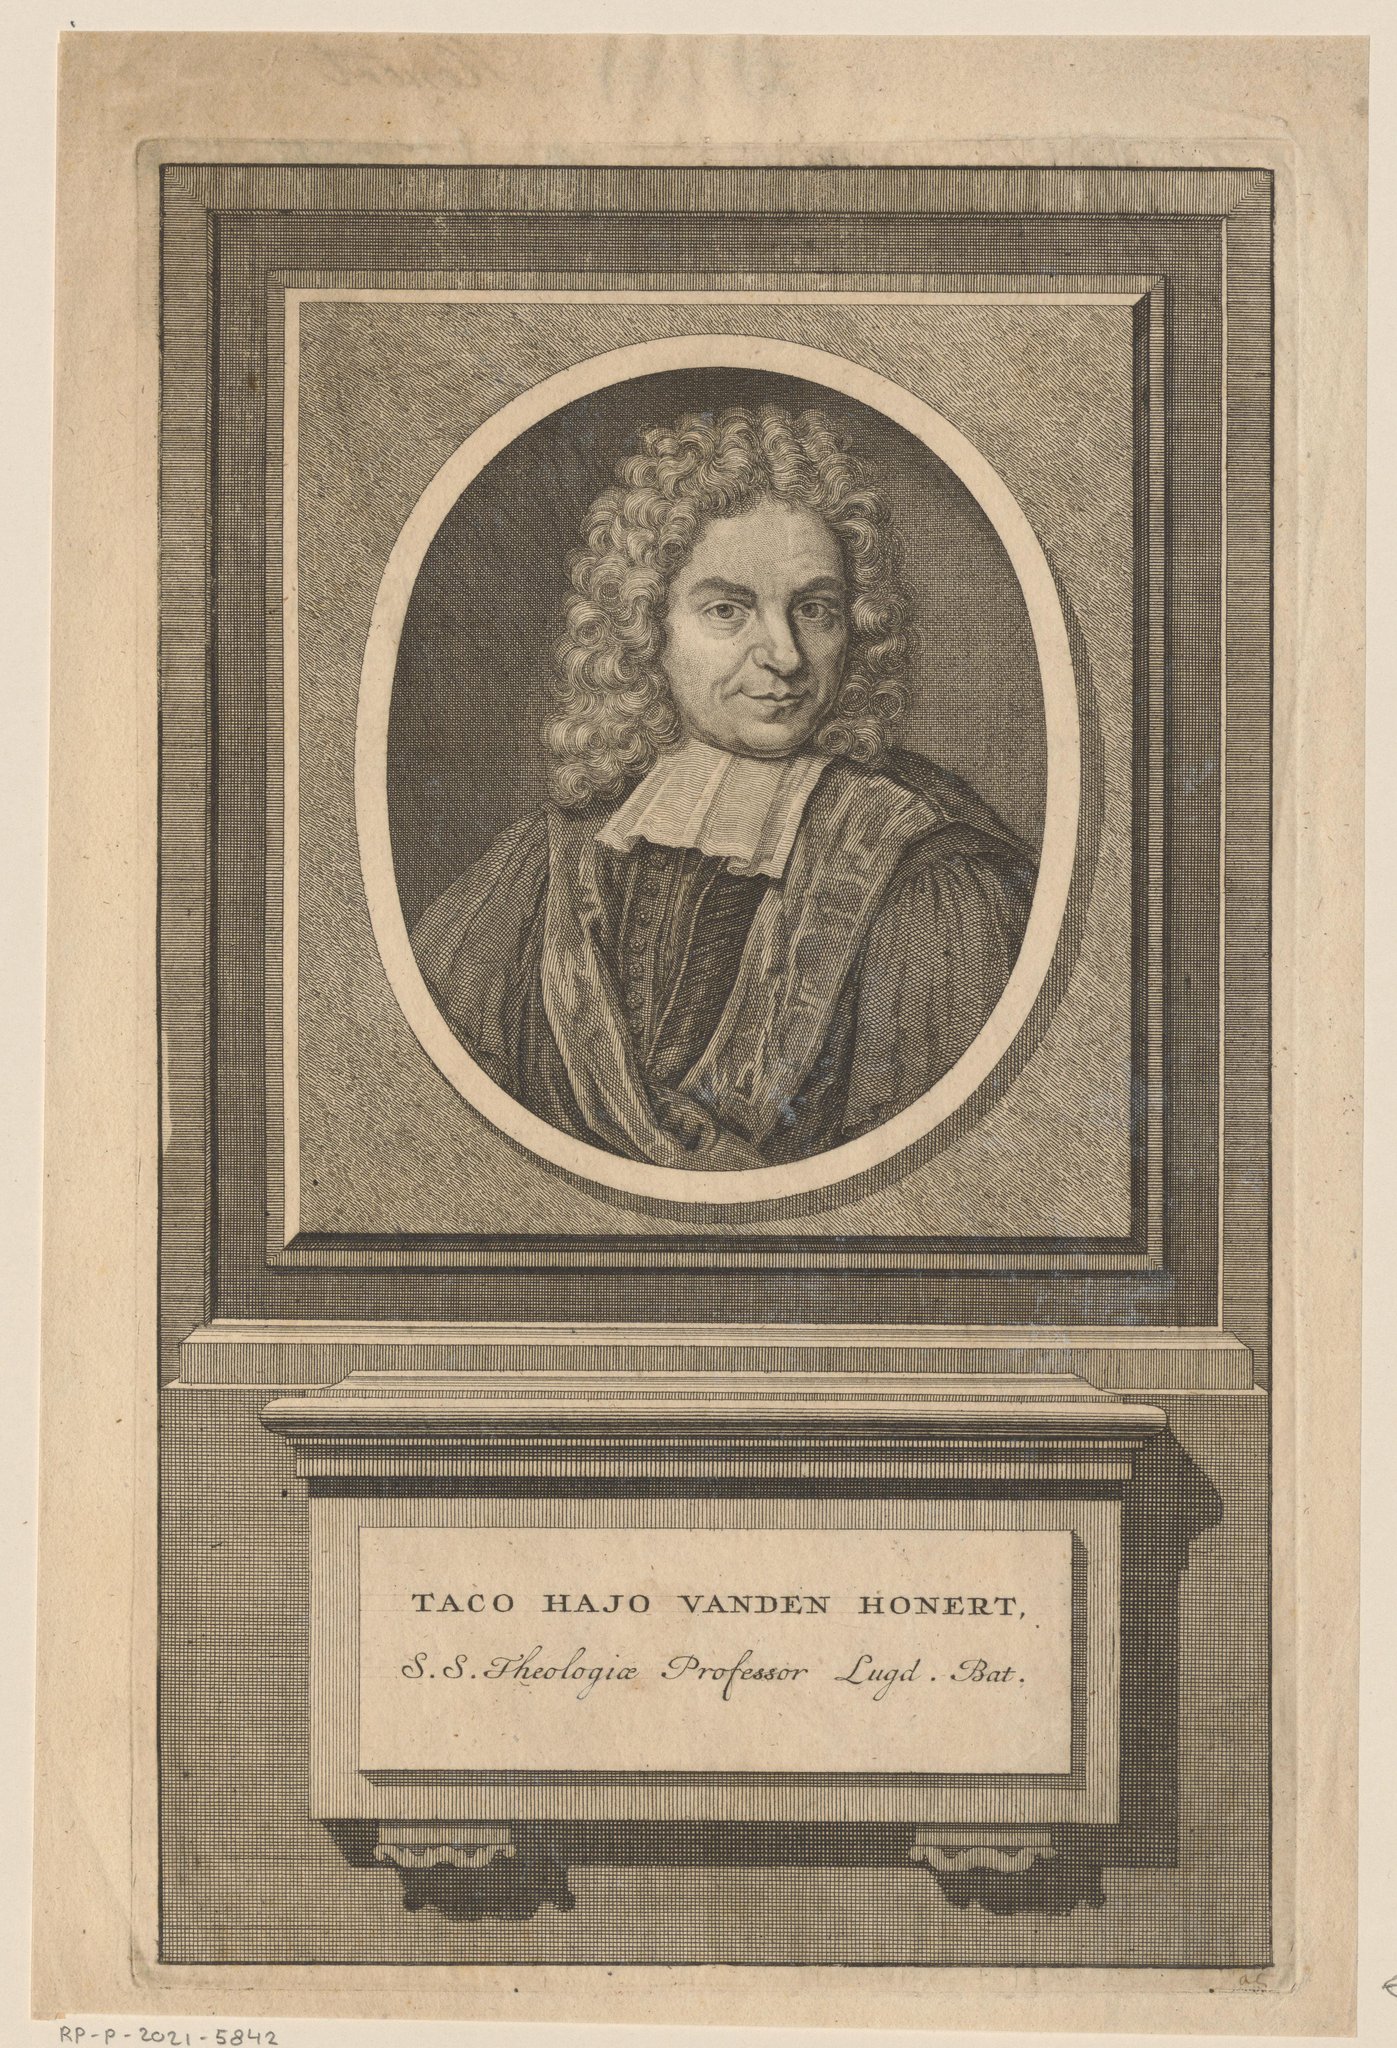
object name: print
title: Portret van Taco Hajo van den Honert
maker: Anonymous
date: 1700-1749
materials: paper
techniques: engraving, etching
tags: leiden, theologian, historical persons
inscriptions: inscription: ‘Henert’